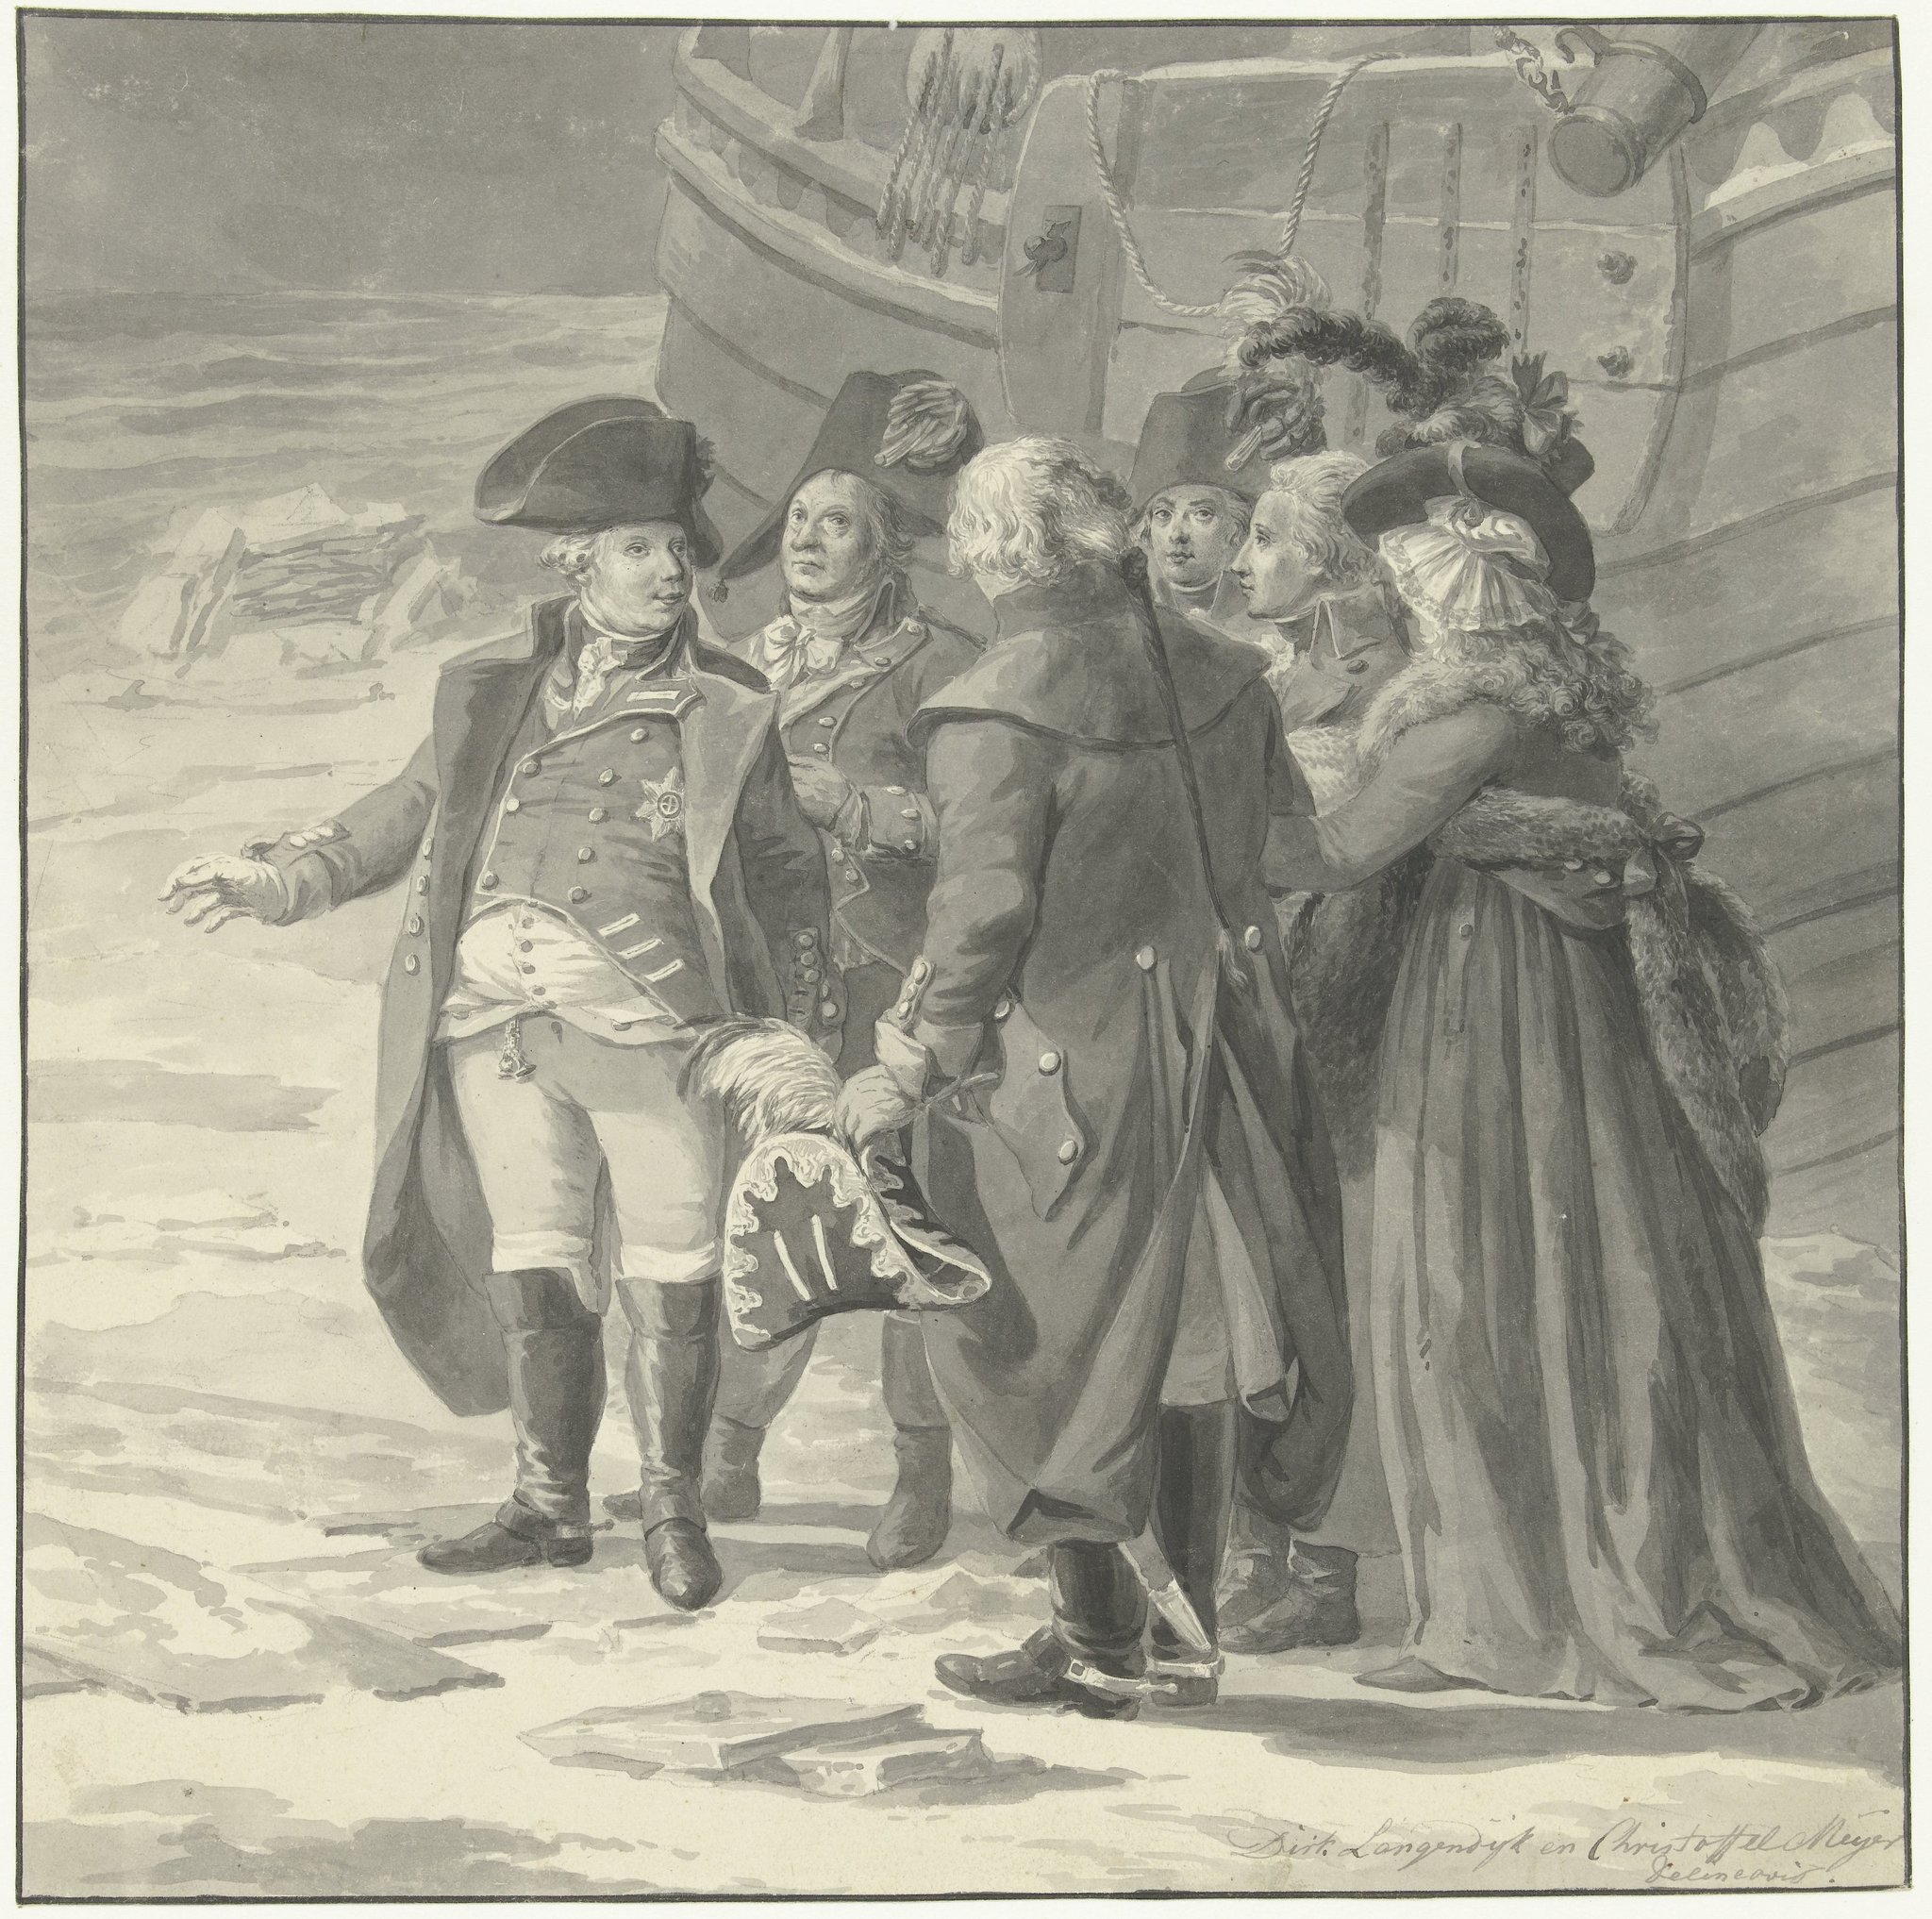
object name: drawing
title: Het vertrek van Willem V naar Engeland, 18 januari 1795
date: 1795-1813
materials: ink, paper, pencil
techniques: brush, pen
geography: netherlands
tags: the hague, william v (prince of orange)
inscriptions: date: ‘december’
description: Voorstudie voor de prent van het vertrek van Willem V naar Engeland, 17 januari 1795.